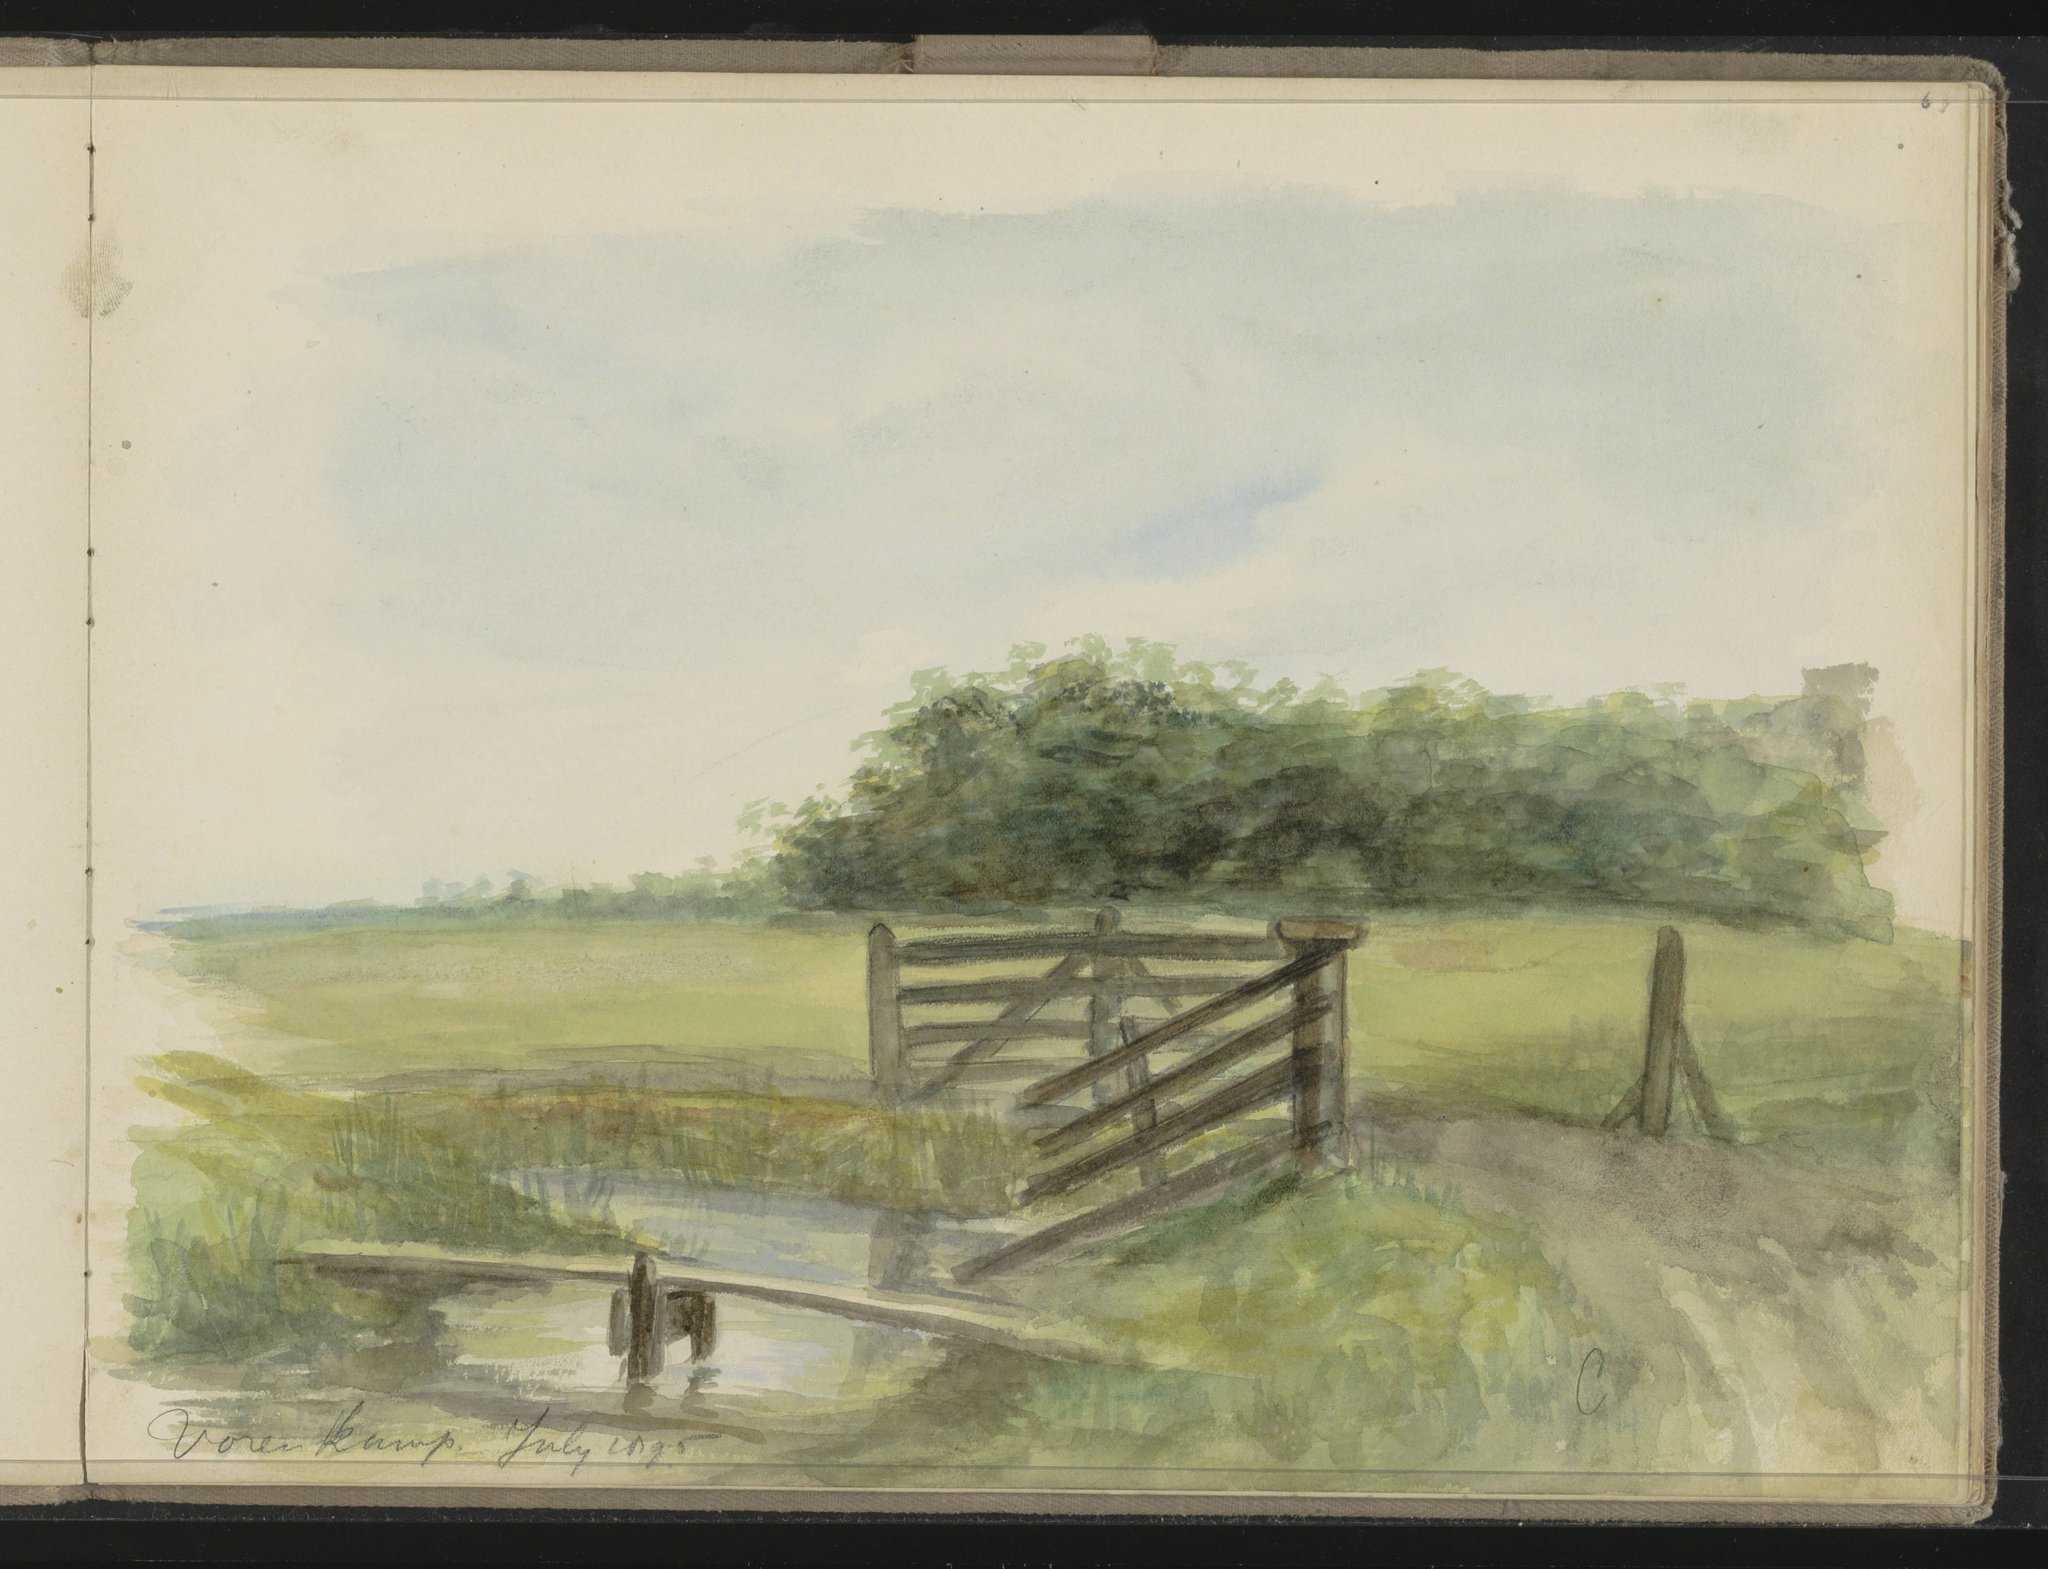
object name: sketchbook leaf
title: Landschap bij uitspanning Vorenkamp te Groningen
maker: chris huidekooper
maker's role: draughtsman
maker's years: 1878-1939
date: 1807-1895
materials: paper, pencil, watercolor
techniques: brush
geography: groningen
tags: landscapes, fence, wall, paling, small canal, ditch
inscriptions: date and inscription: ‘Vorenkamp Juli 1895’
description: Blad 6 recto uit een schetsboek met 32 bladen.